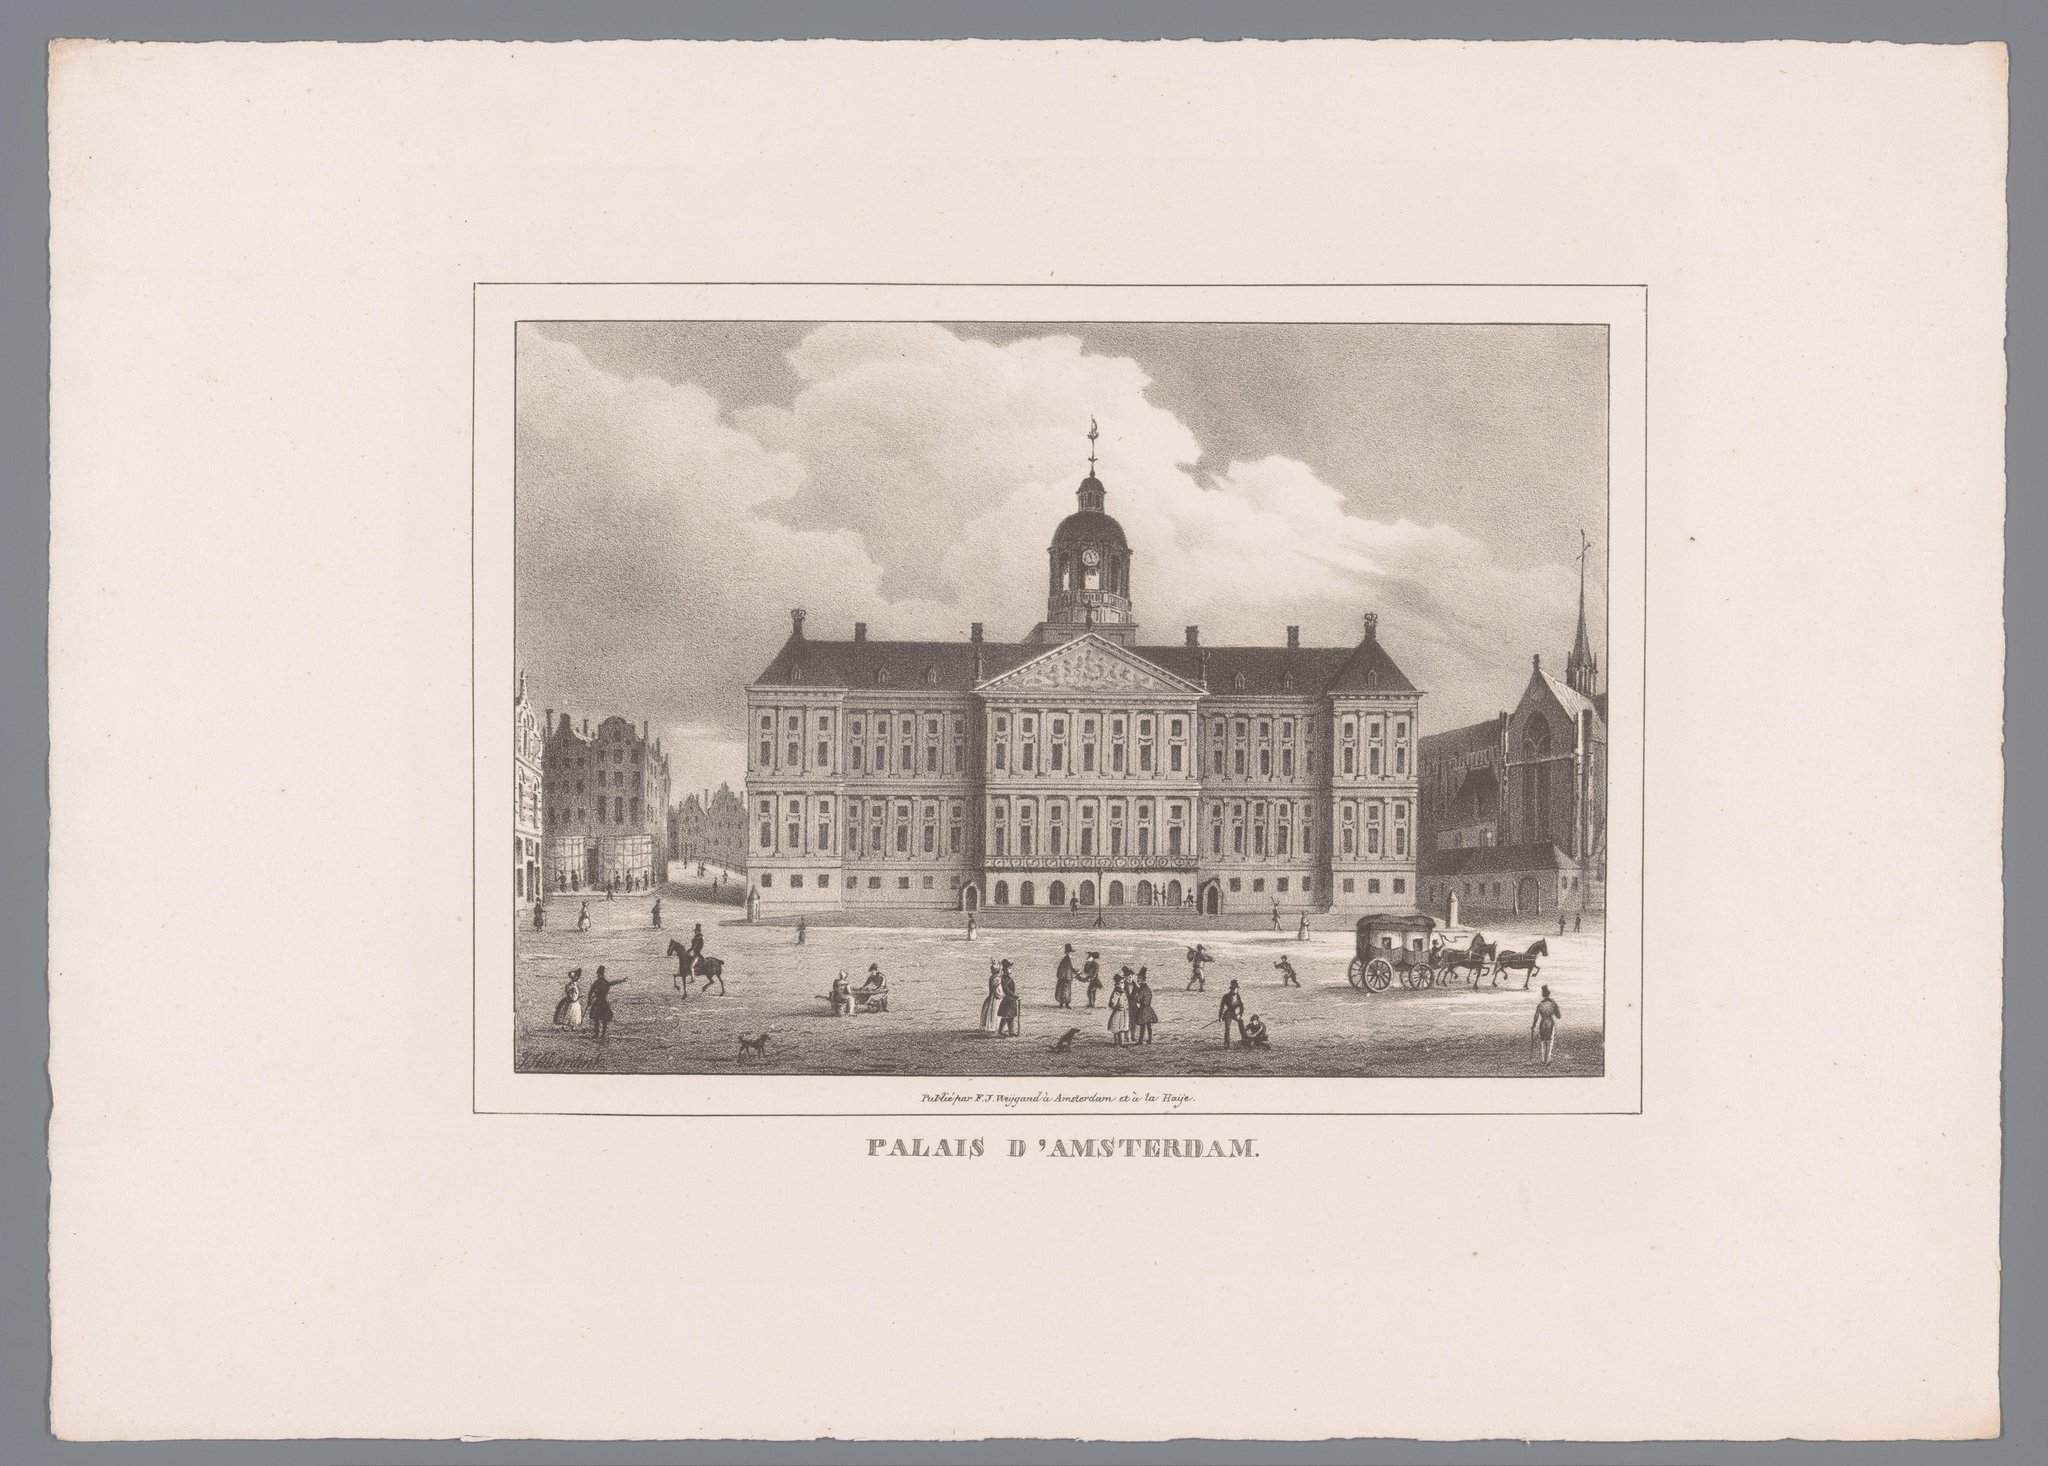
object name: print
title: Palais D'Amsterdam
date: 1850-1860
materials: paper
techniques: lithograph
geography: amsterdam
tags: palace, royal palace of amsterdam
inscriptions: mark